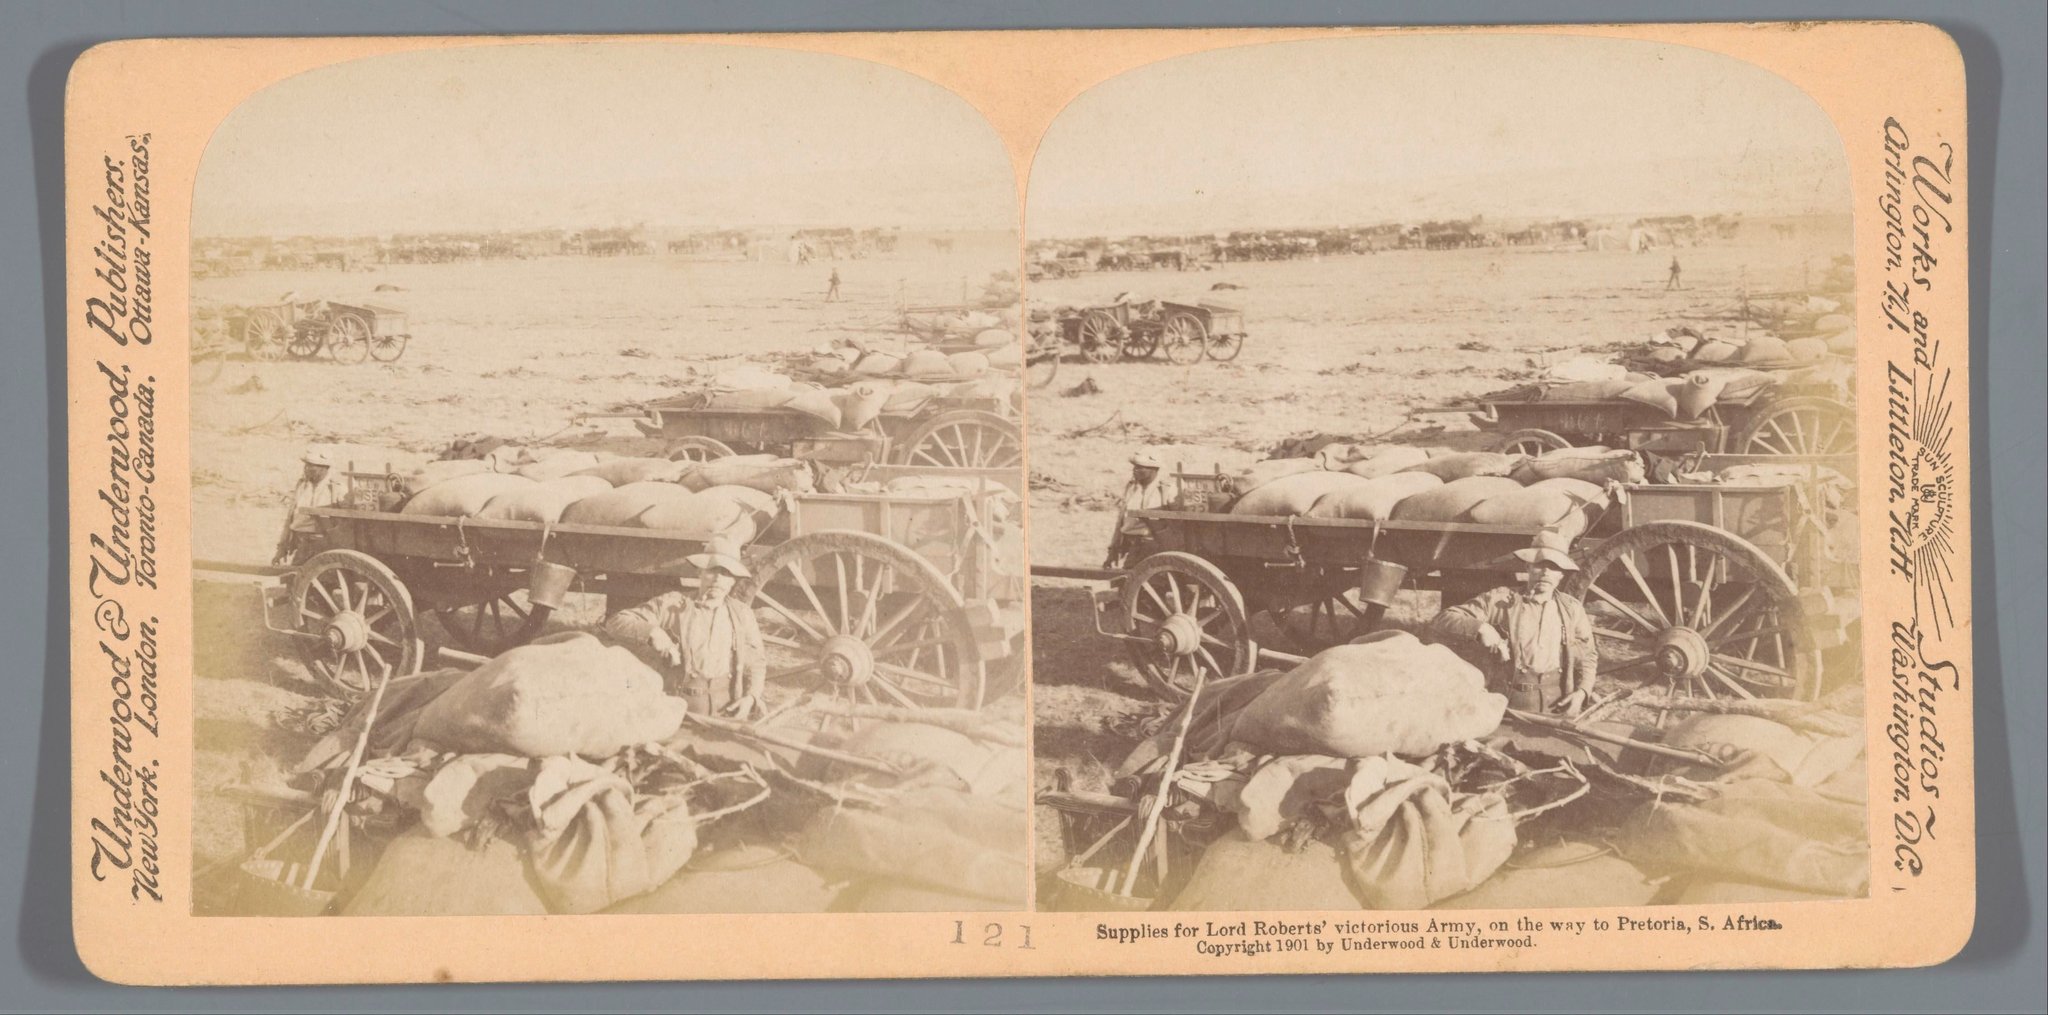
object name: stereograph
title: Gezicht op karren met voorraad onderweg naar het leger van Lord Roberts (Frederick Sleigh Roberts) in Pretoria, Zuid-Afrika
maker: Anonymous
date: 1901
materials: cardboard, paper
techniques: albumen print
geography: new york city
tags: transporting of food ~ military service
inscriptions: copyright notice: ‘Copyright 1901 by Underwood & Underwood.’, number: ‘121’, inscription: ‘Works and Studios ~/ Arlington, N.J. Littleton, N.H. Washington, D.C.’, inscription